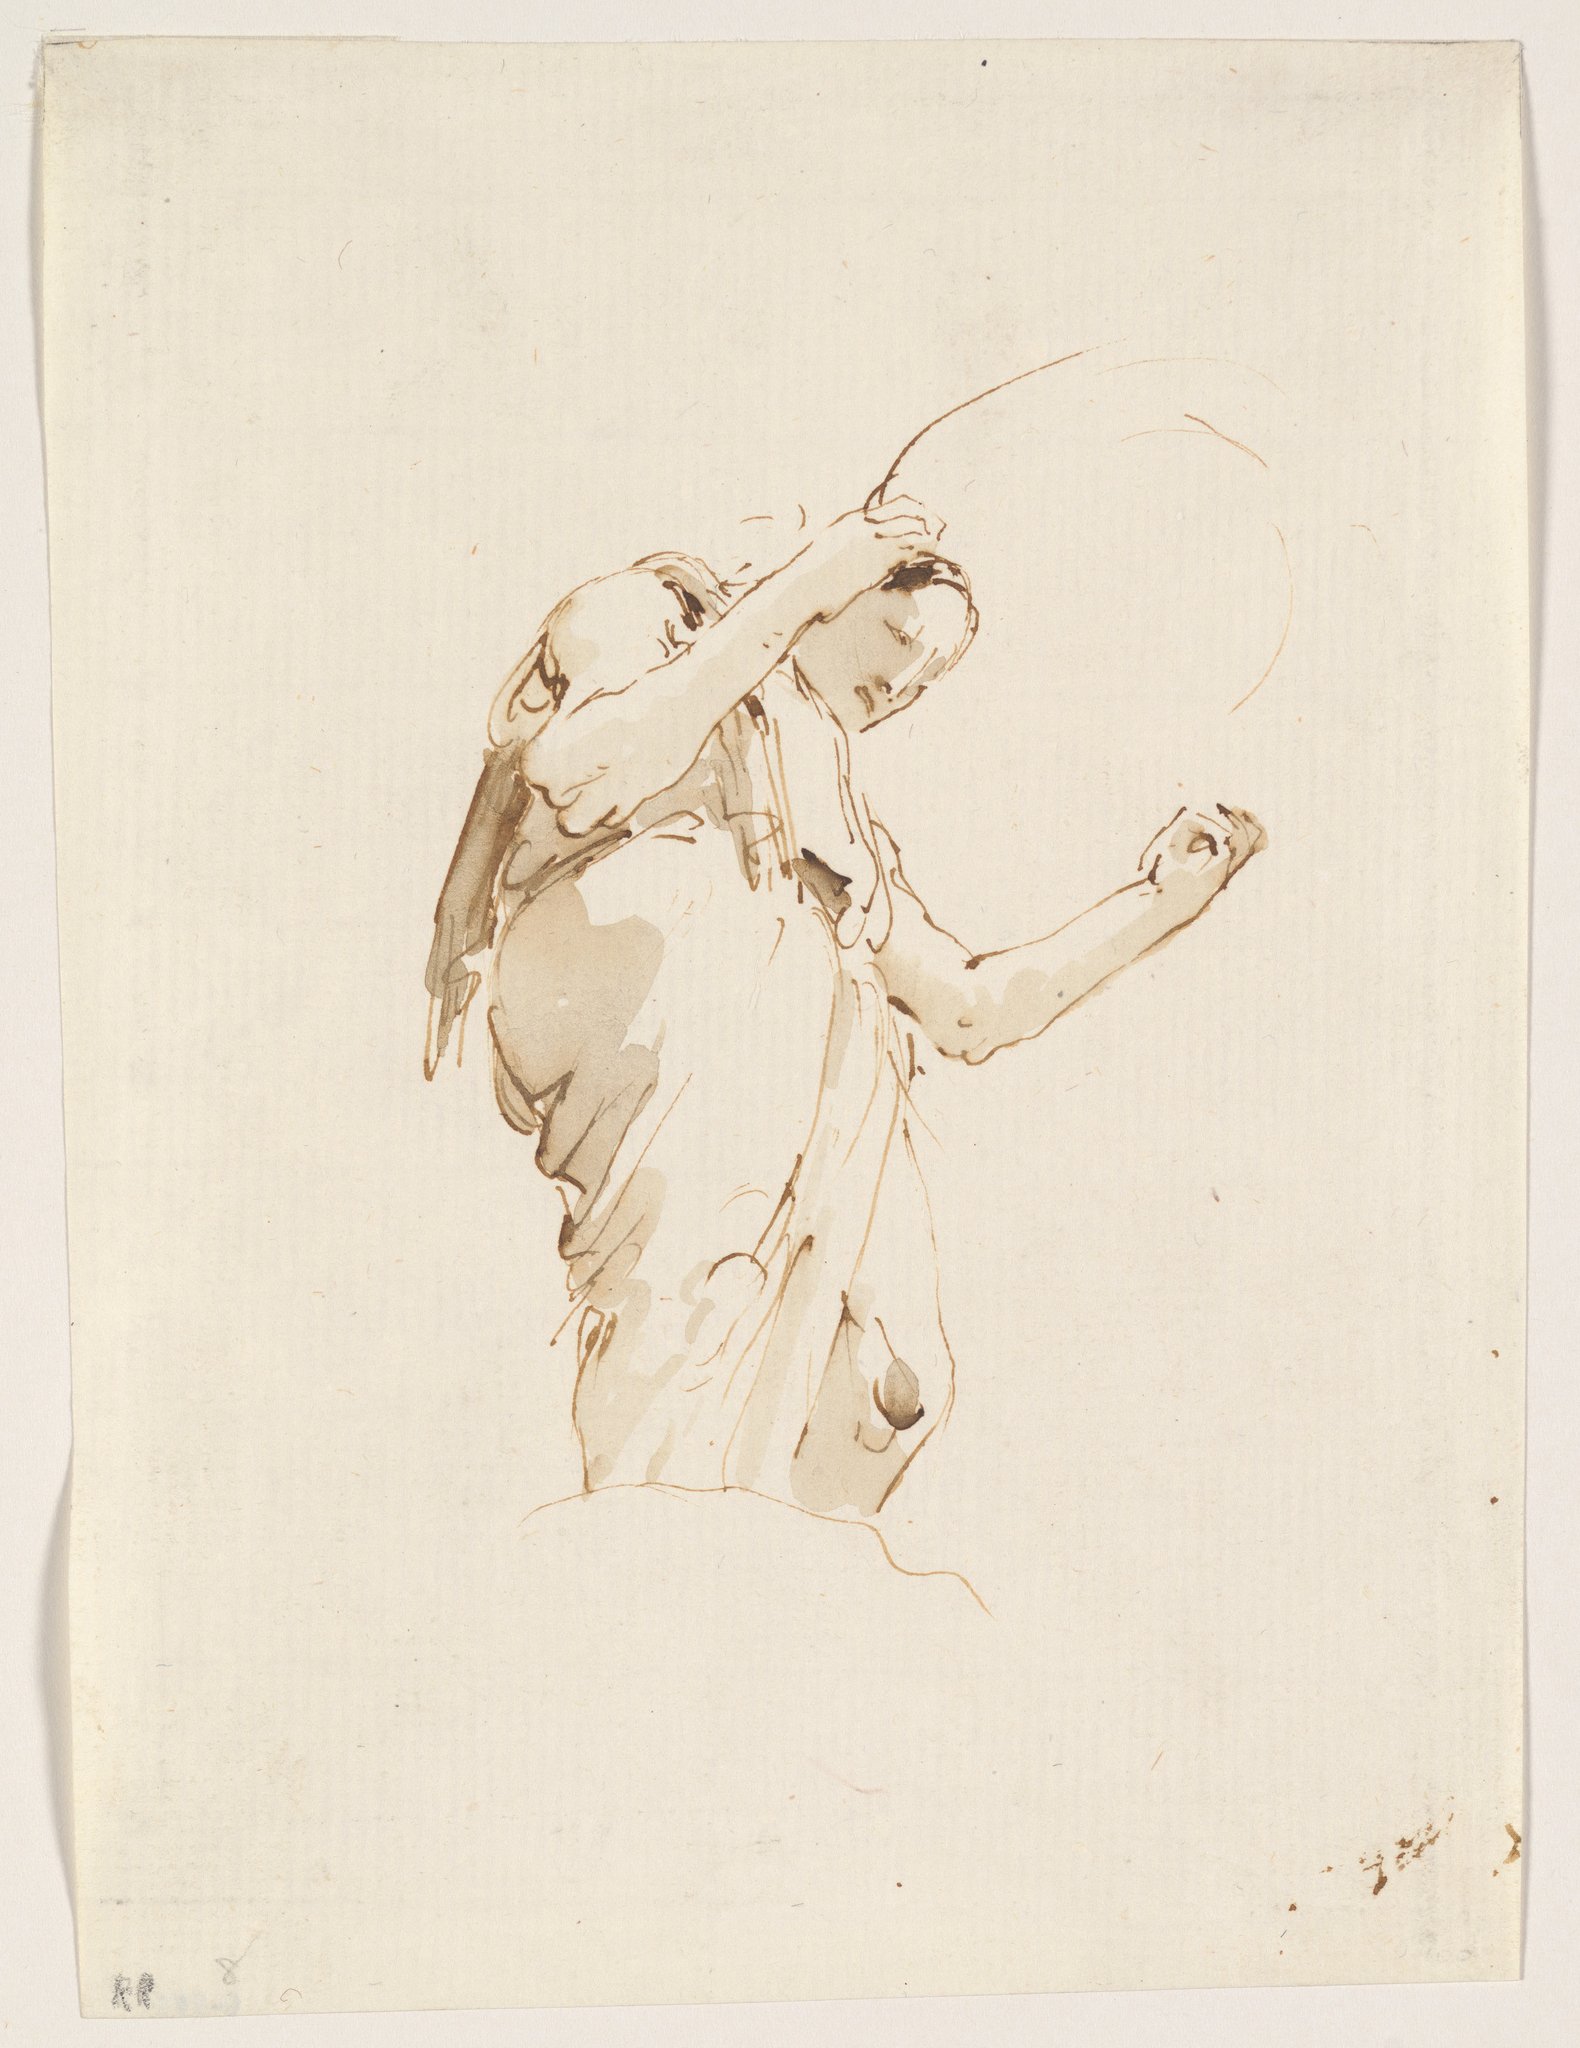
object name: drawing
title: Standing Woman Holding a Hoop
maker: giovanni battista tiepolo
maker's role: artist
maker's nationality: italian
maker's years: 1696-1770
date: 1742-1757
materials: ink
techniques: pen, wash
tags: women